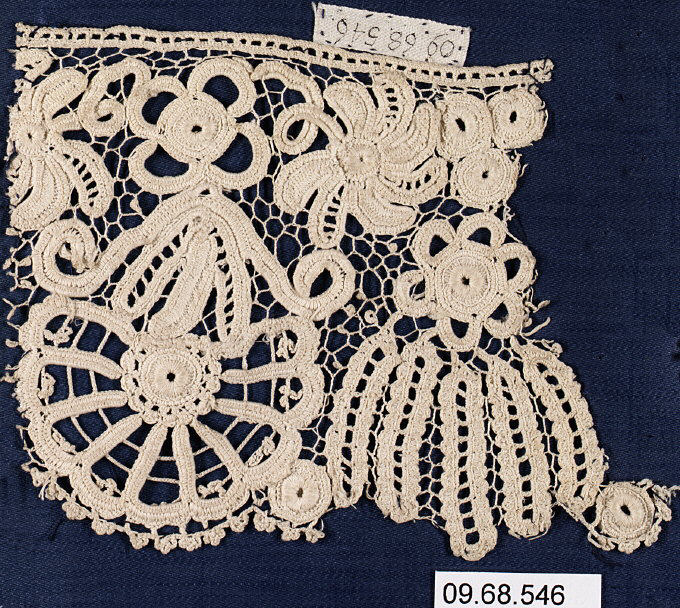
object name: specimen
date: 1801-1900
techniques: crochet